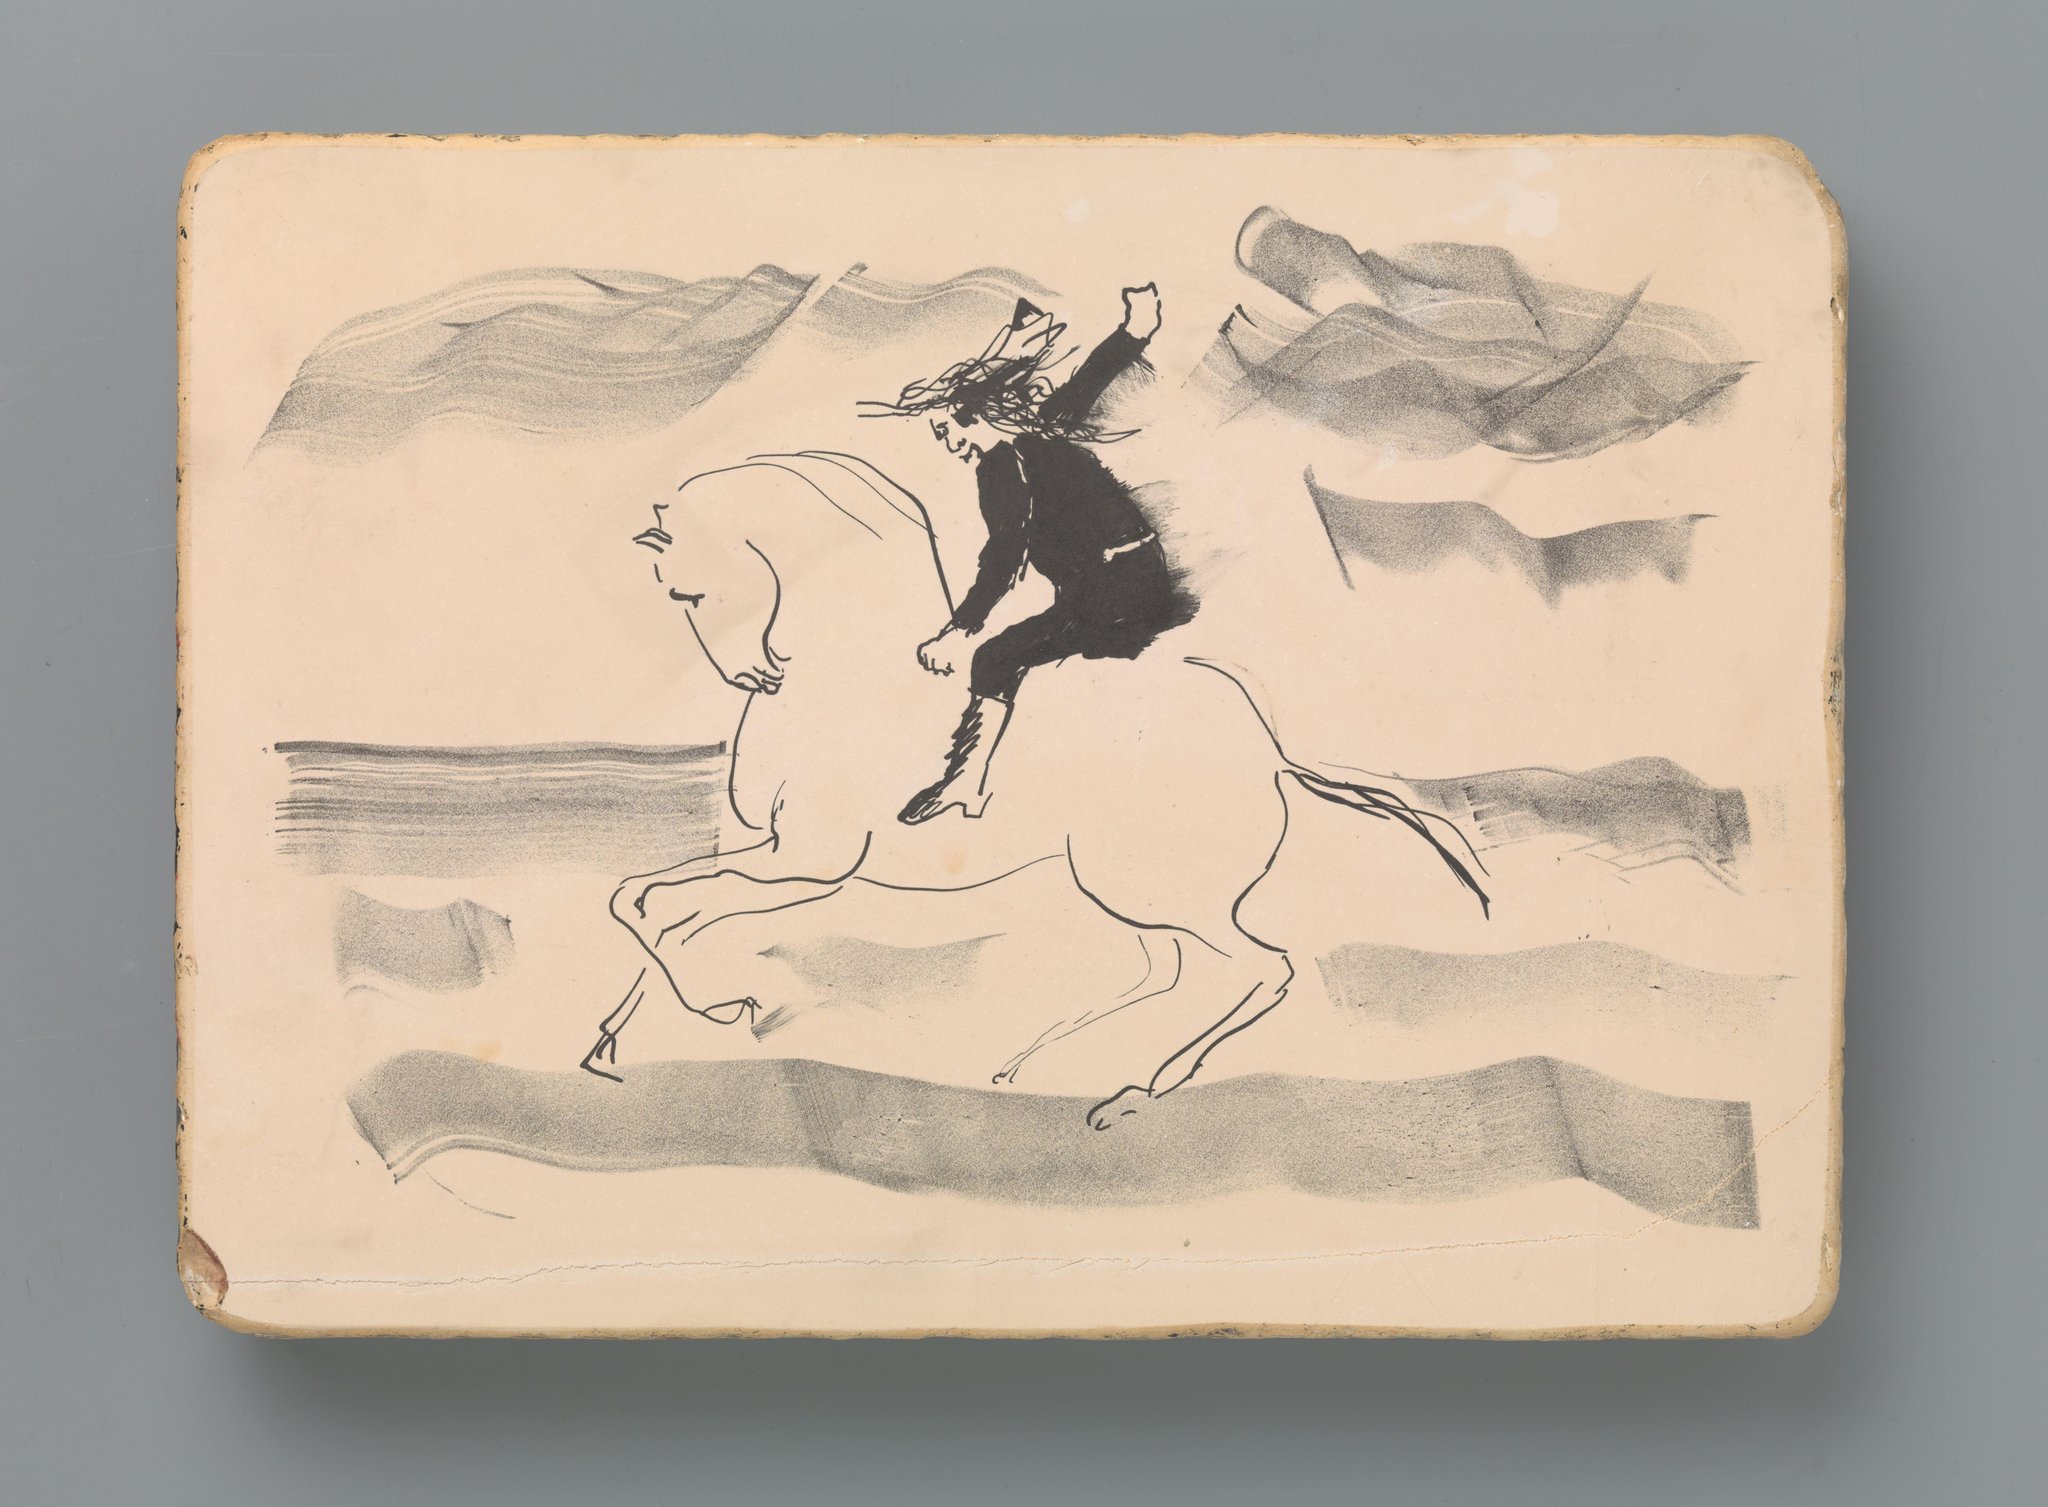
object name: lithographic stone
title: Ruiter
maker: Anonymous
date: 1970-1990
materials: stone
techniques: lithograph